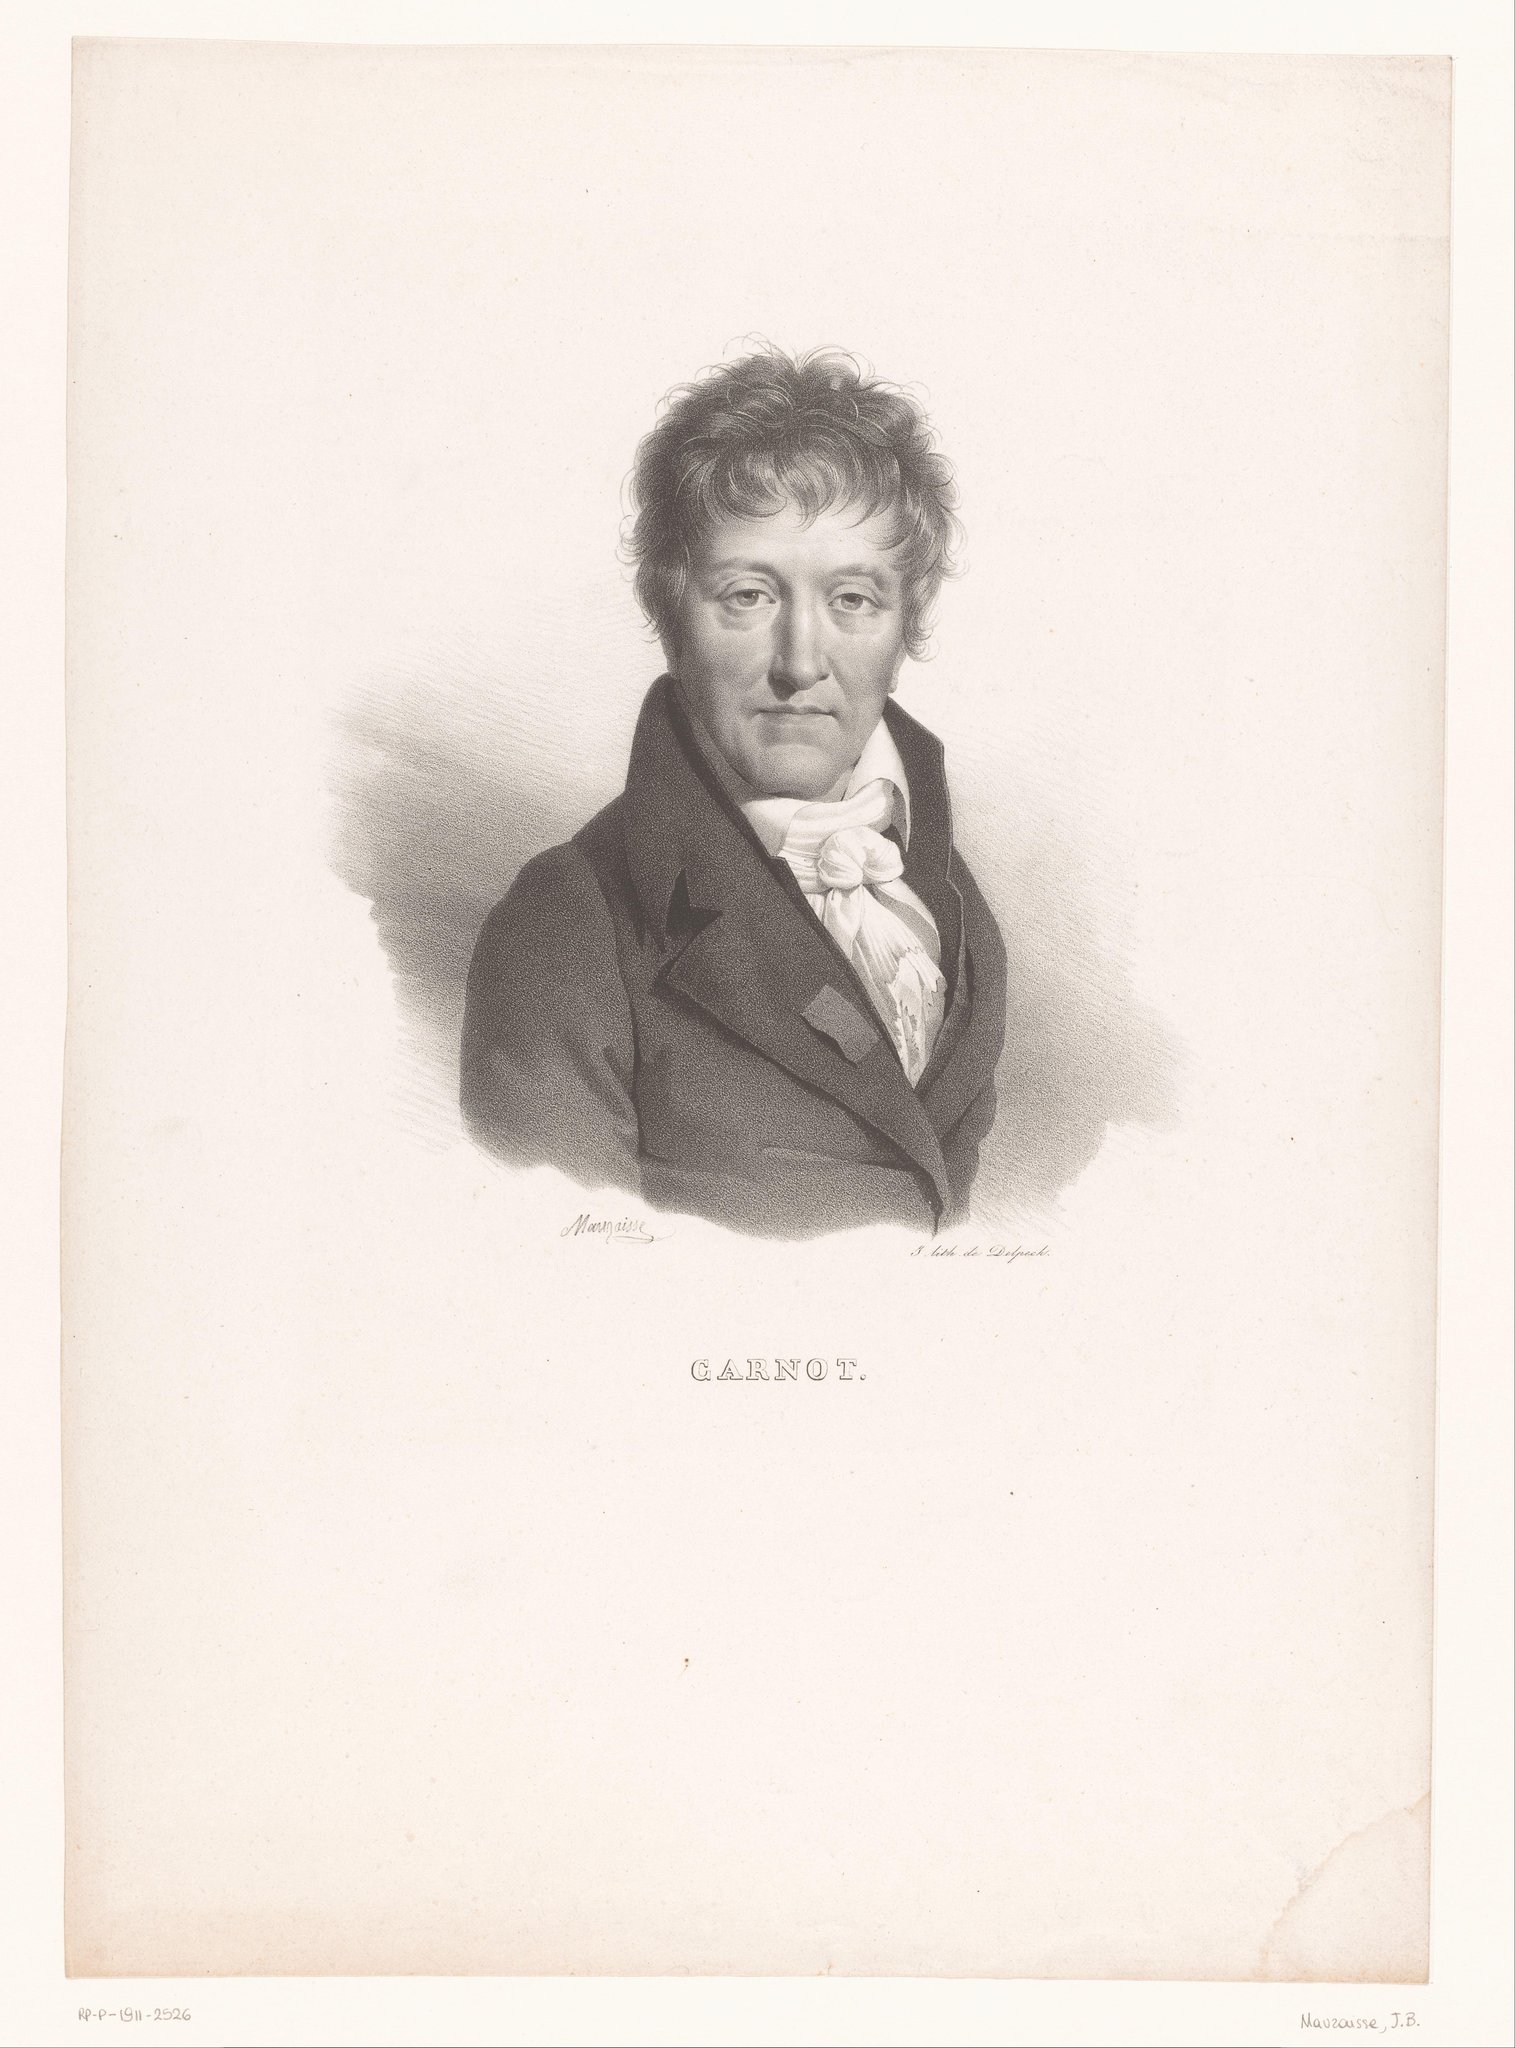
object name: print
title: Portret van Lazare Carnot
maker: jean baptiste mauzaisse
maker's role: print maker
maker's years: 1784-1844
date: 1818-1842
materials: paper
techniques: lithograph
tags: historical persons, politician, e.g. party leader, the soldier; the soldier's life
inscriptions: collector's mark: Lugt 2228